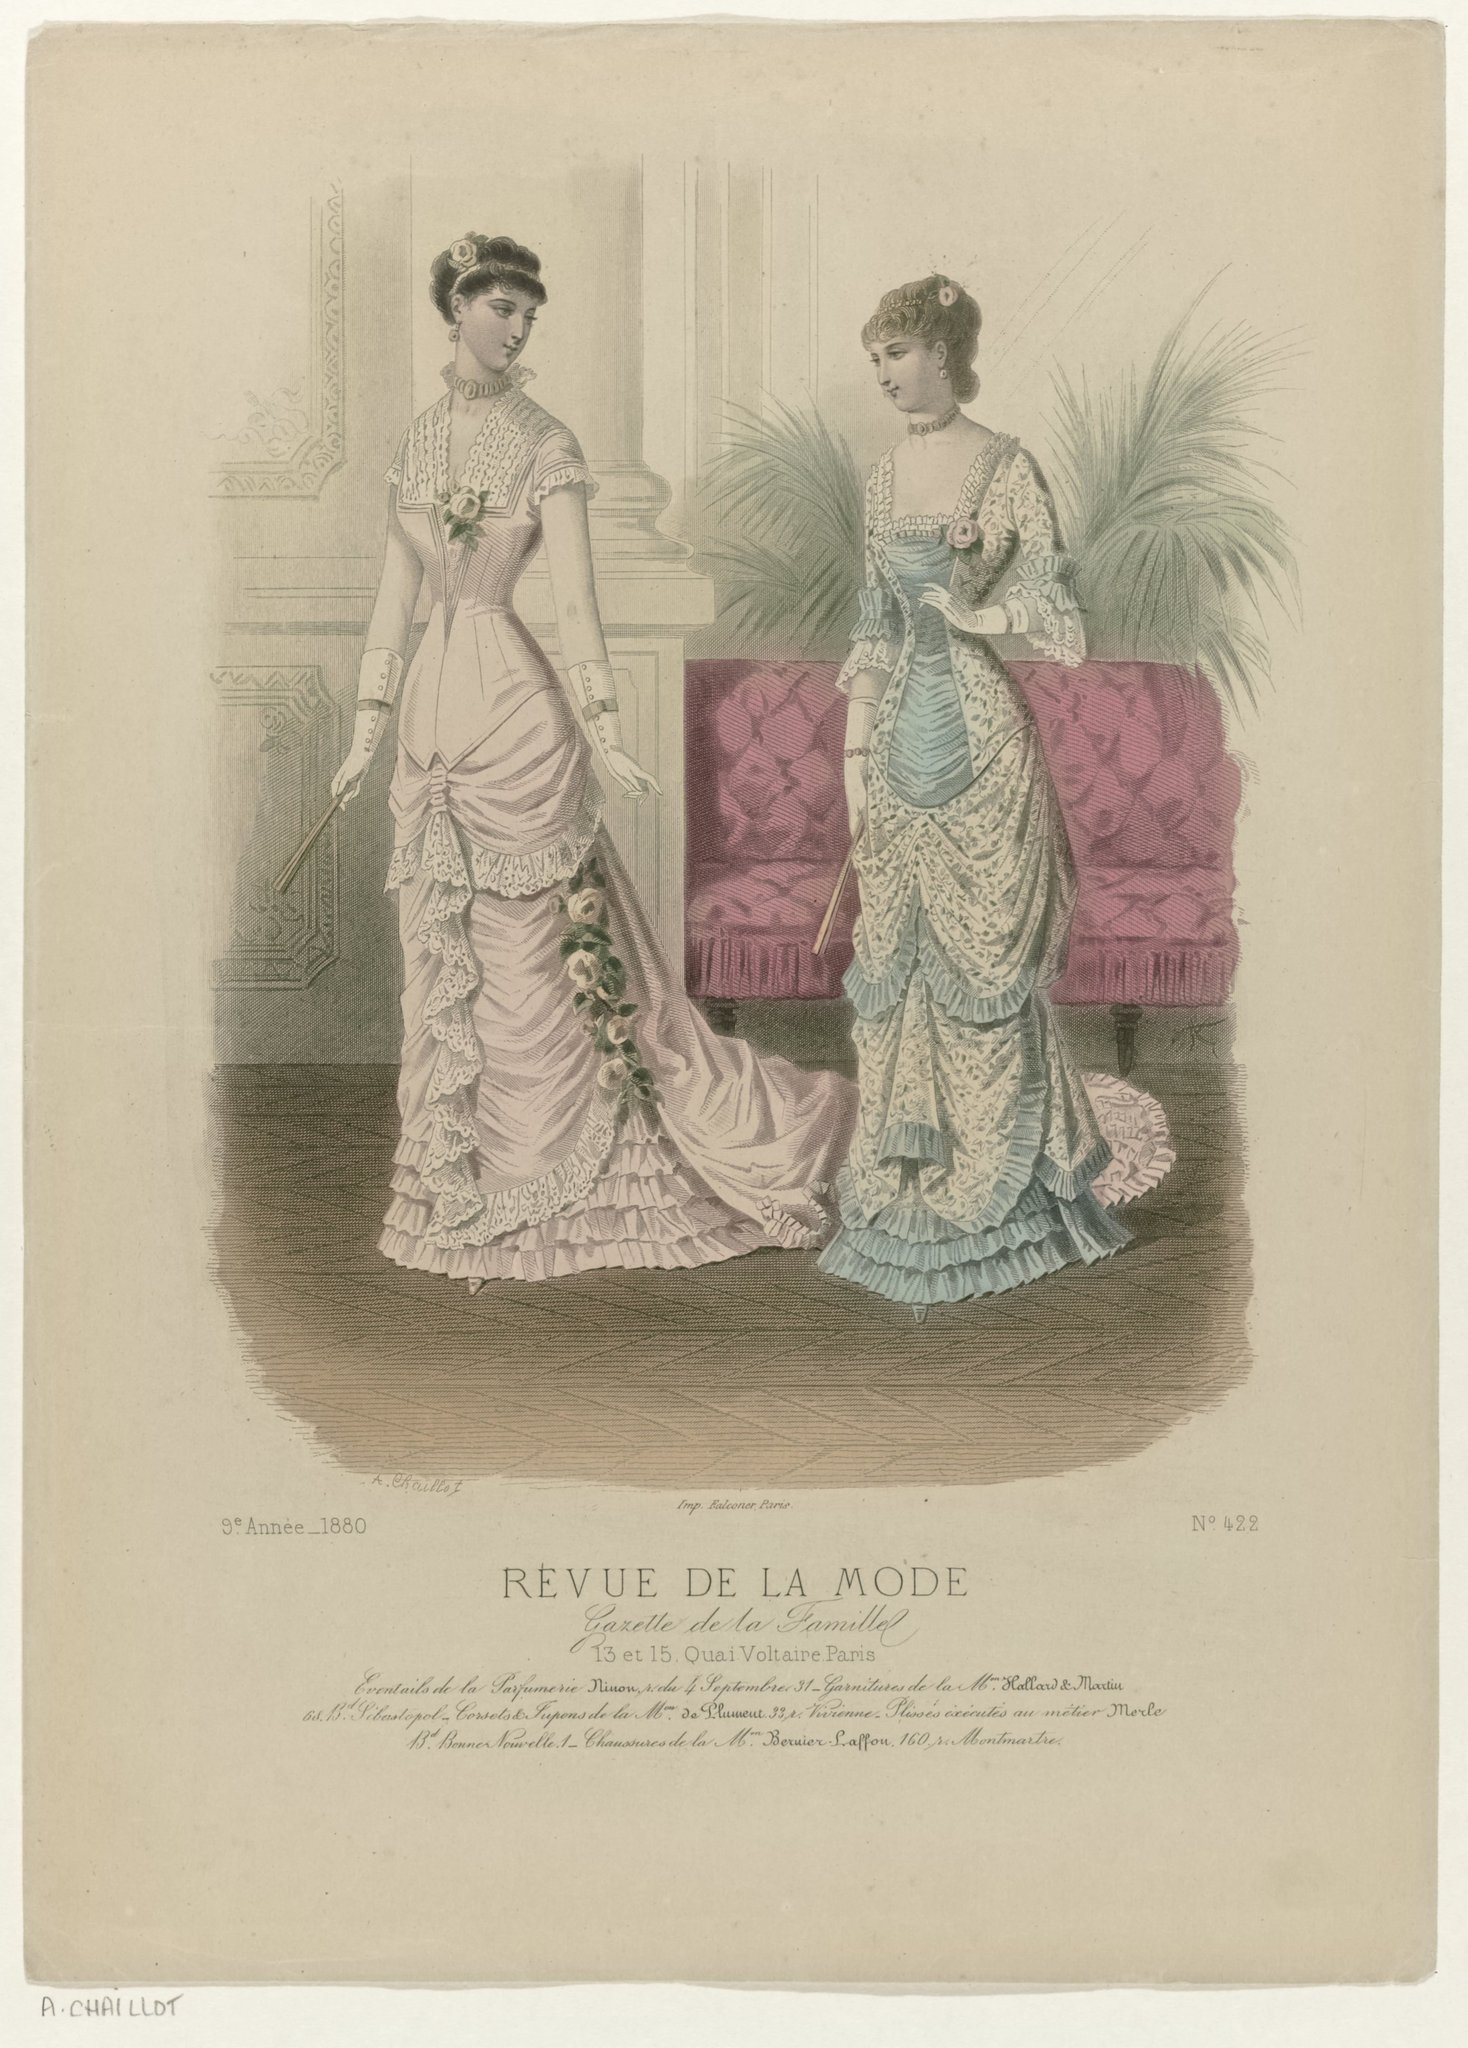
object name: fashion print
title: Revue de la Mode, Gazette de la Famille,dimanche 1 février 1880, 9e année, No. 422: Eventails de la Parfumerie Ninon (...)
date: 1880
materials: paper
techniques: engraving, hand coloring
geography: paris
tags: corsage (+ women's clothes), flowers, ear-rings (+ women's clothes), dress, gown: evening dress (+ women's clothes), gloves, mittens (long gloves) (+ women's clothes), dress, gown: ball gown (+ women's clothes), lace (+ women's clothes), fashion plates, fan (+ women's clothes), bracelet, wristlet (+ women's clothes), necklace (+ women's clothes)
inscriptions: caption: ‘Eventails de la Parfumerie Ninon, r. du 4 Septembre 31_Garnitures de la M.on Hallard & Martin 68, B.d Sébastopol_Corsets & Jupons de la M.on de Plument, 33 r, Vivienne_ Plissés éxécutés au métier Merle B.d Bonne Nouvelle 1_ Chaussures de la M.on Bernier-Laffon, 160,r. Montmartre.’, address: ‘13 et 15, Quai Voltaire, Paris’, title: ‘REVUE DE LA MODE / Gazette de la Famille’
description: Twee vrouwen in een interieur voor een sofa. Links: roze baljapon. Rechts: 'toilette pompadour', voor een bal of soirée, met halflange mouwen 'à sabot' van kant. Onder de voorstelling enkele regels reclametekst voor verschillende producten. Prent uit het modetijdschrift Revue de la Mode (1872-1913). Uitgebreide beschrijving van de kleding op pagina 44 "PLANCHE COLORIÉE".